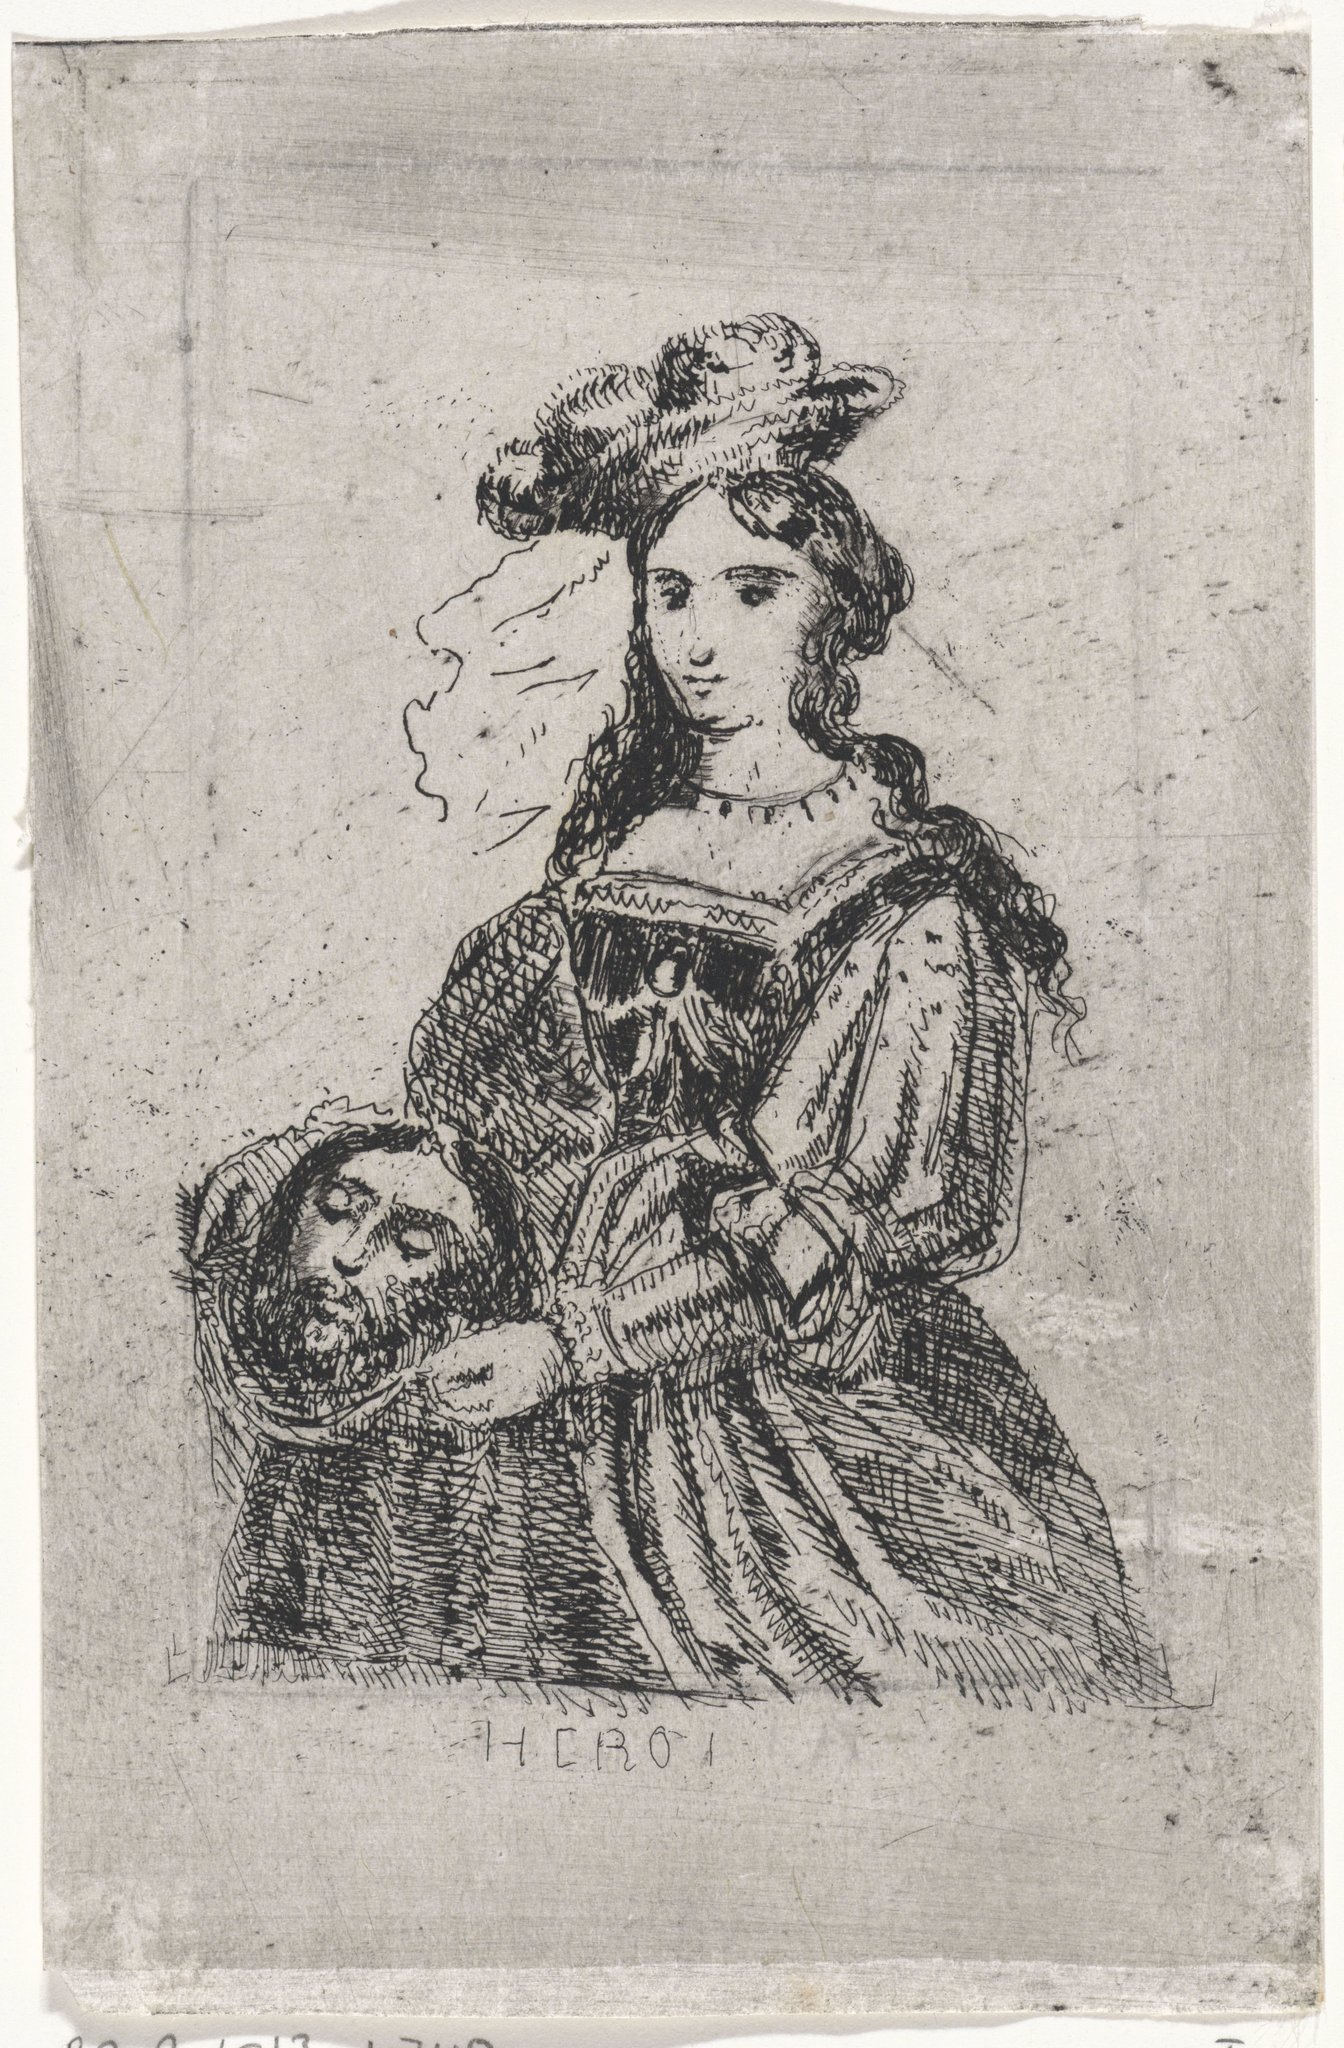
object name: print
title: Salome met het hoofd van Johannes de Doper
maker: arnoud schaepkens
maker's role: print maker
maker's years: 1816-1904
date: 1831-1904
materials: paper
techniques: drypoint, etching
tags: the head of john the baptist on a platter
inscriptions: collector's mark: Lugt 2228